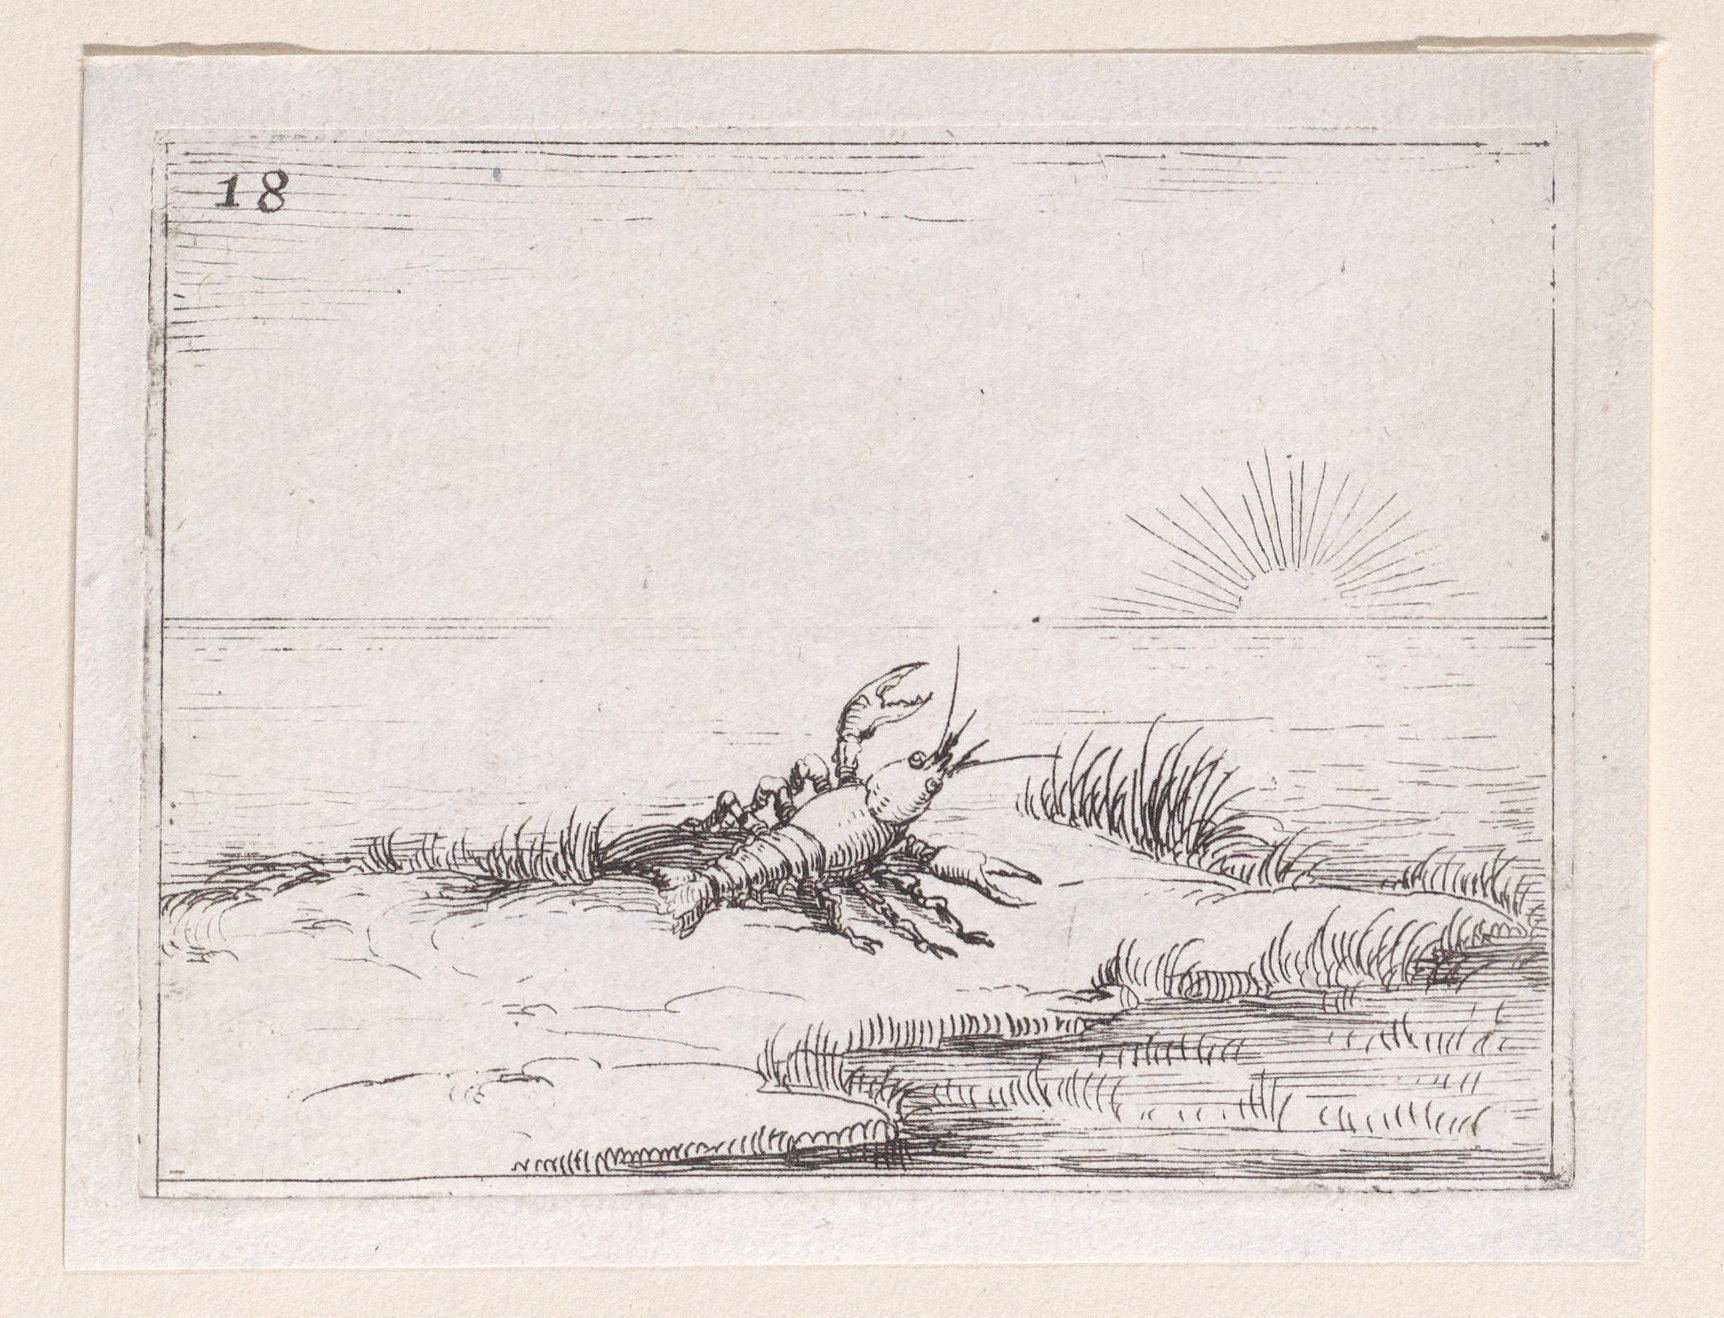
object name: print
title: Une Ecrevisse Regardant le Soleil (A Crayfish Looking at the Sun), plate 18 from "Lux Claustri ou La Lumière du Cloitre" (The Light of the Cloisters)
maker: jacques callot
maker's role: artist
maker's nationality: french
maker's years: 1592-1635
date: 1621-1635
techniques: etching